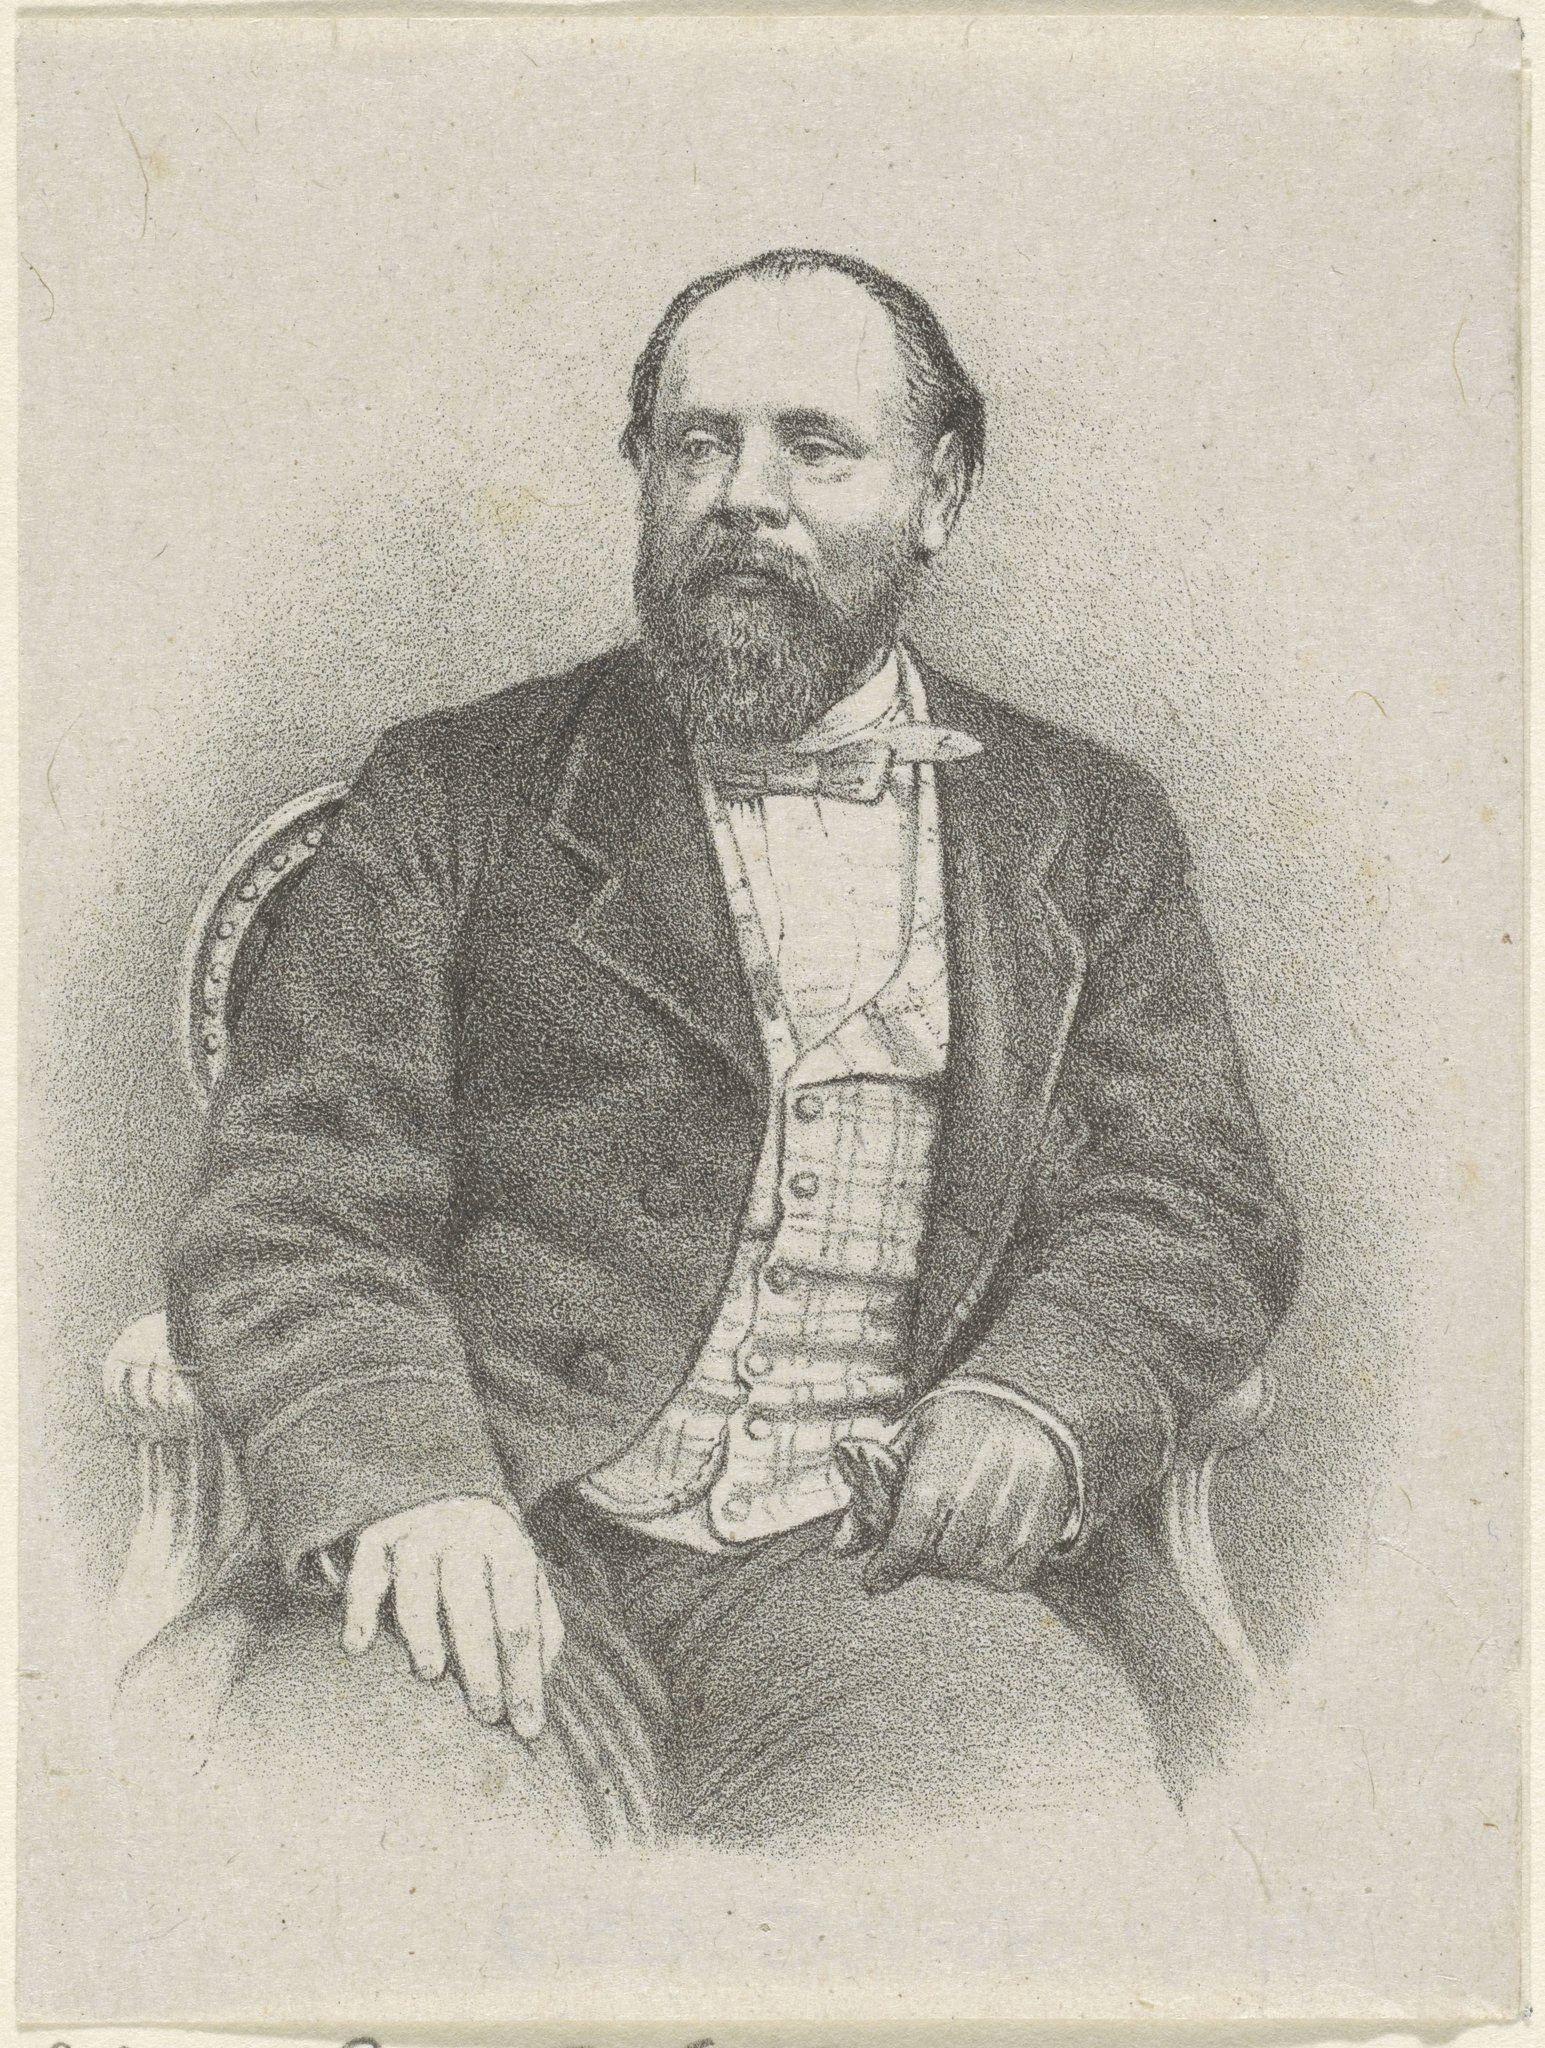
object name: print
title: Portret van Willem III, koning der Nederlanden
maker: Anonymous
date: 1849-1899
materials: paper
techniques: lithograph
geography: netherlands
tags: brussels, willem iii (koning der nederlanden)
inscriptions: collector's mark: Lugt 2228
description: De hier vermelde titel verwijst naar de hoogst verkregen titel van de geportretteerde, niet per se naar de titel die de geportretteerde op deze voorstelling draagt.